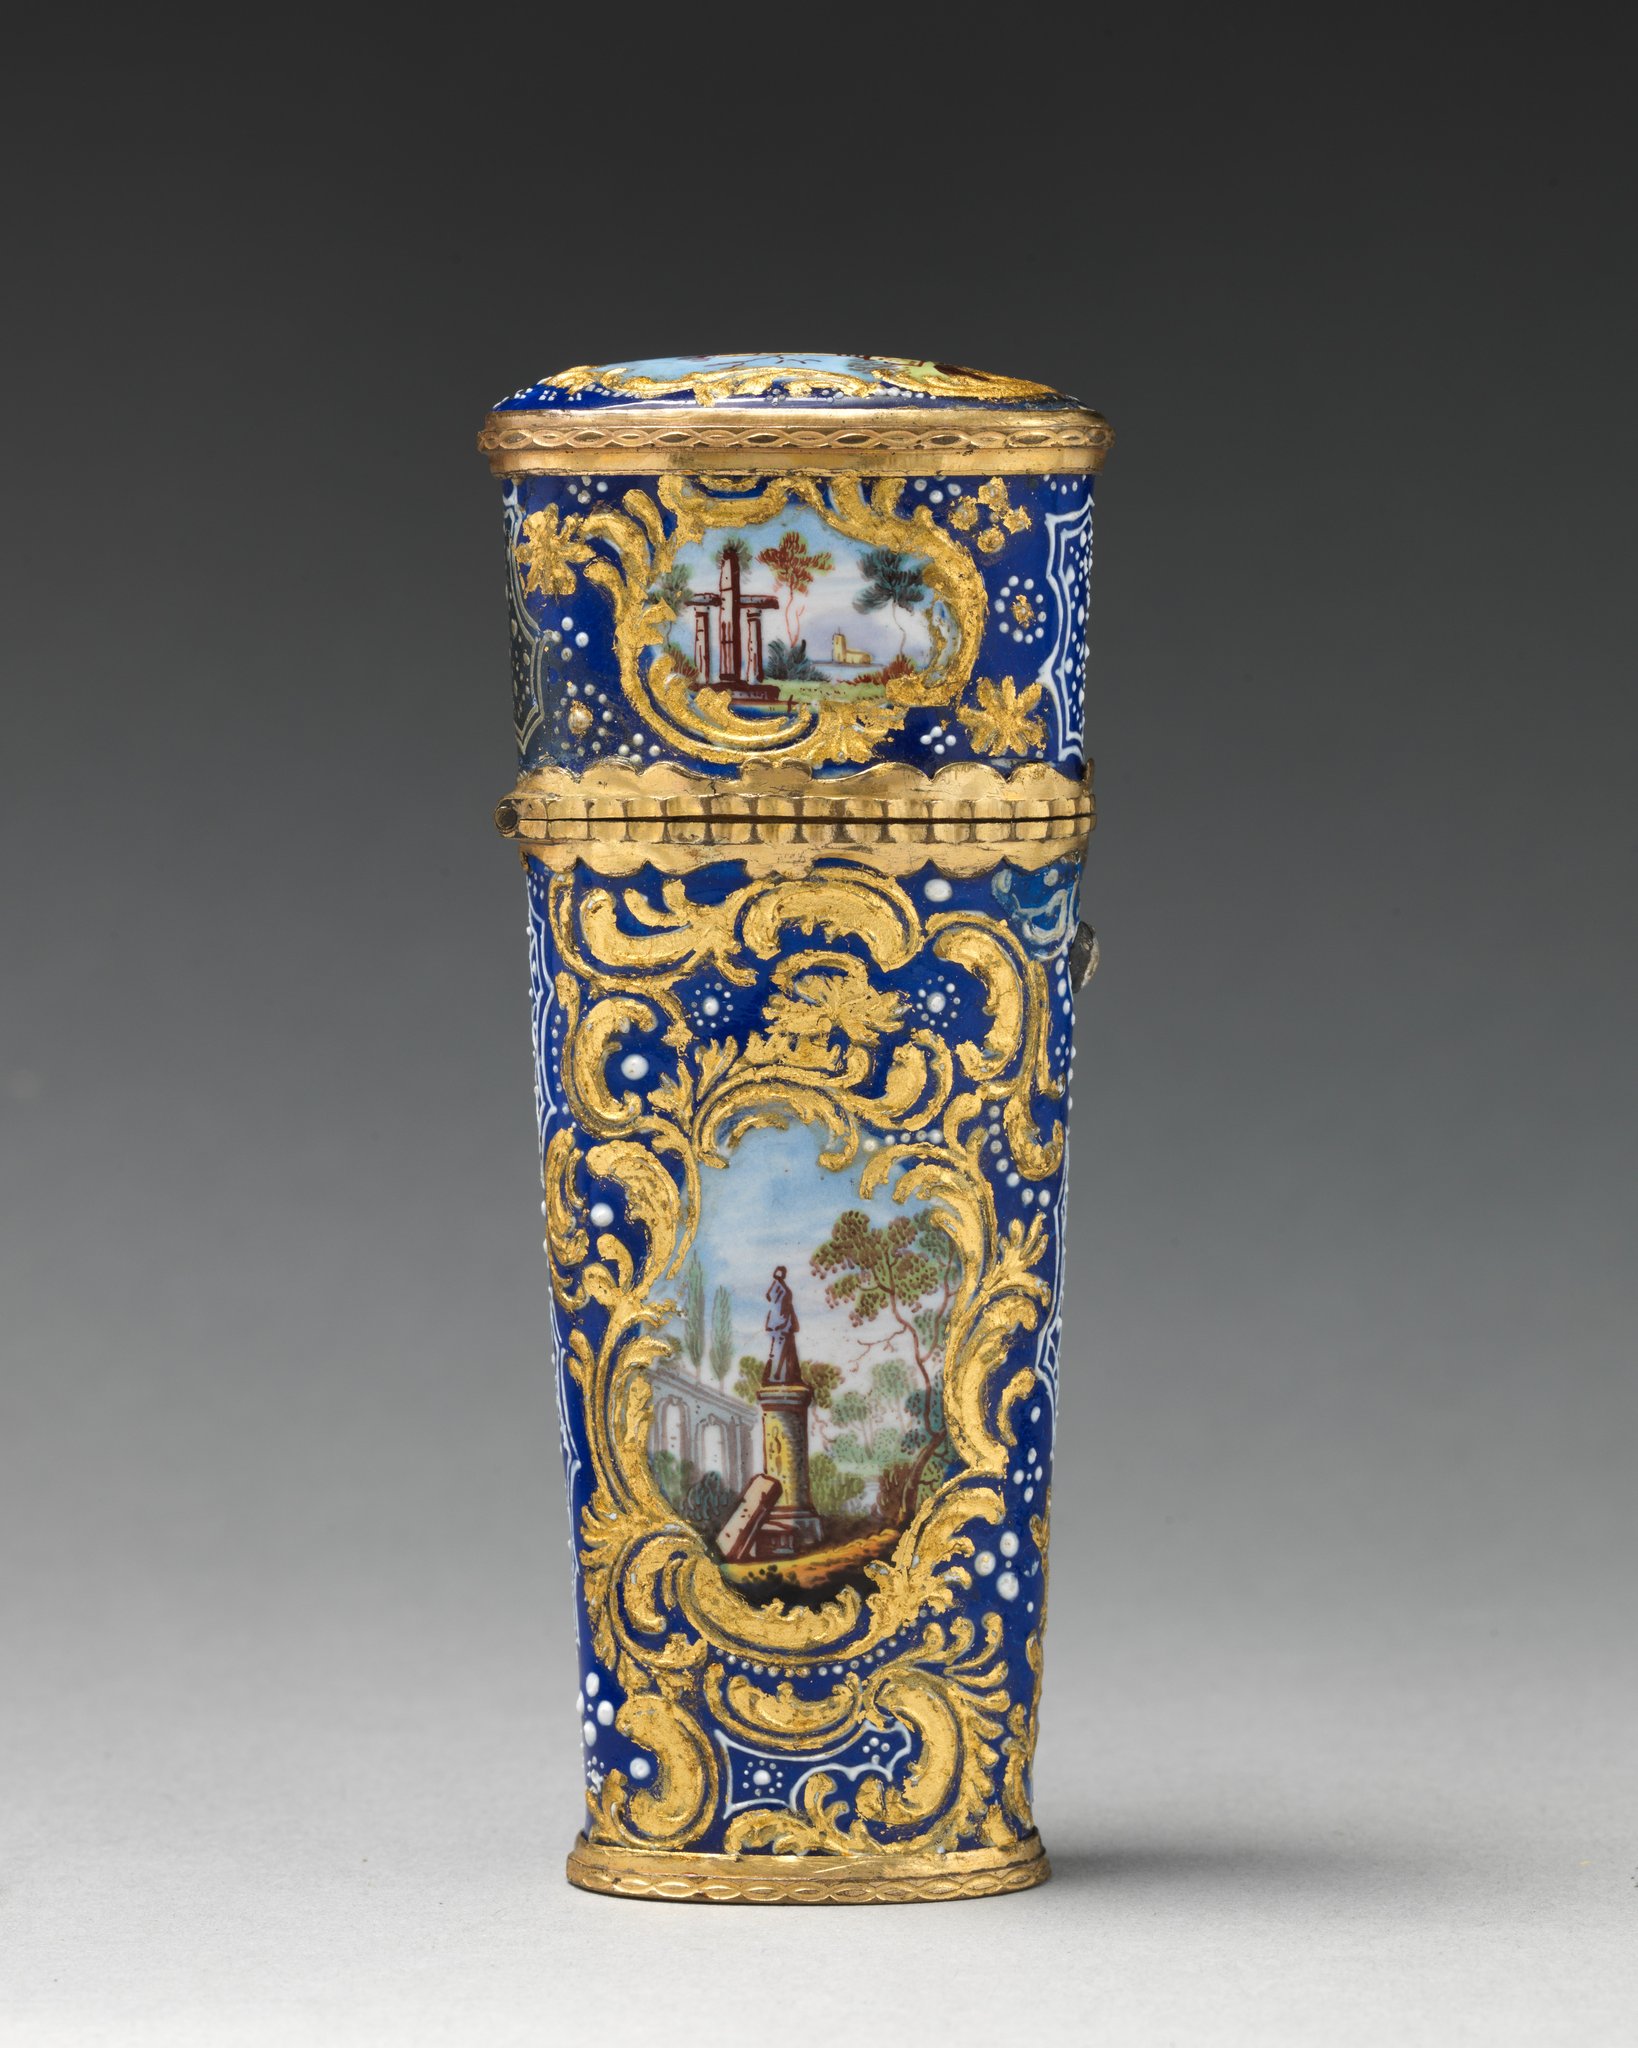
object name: étui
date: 1765-1770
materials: copper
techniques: enamel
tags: trees